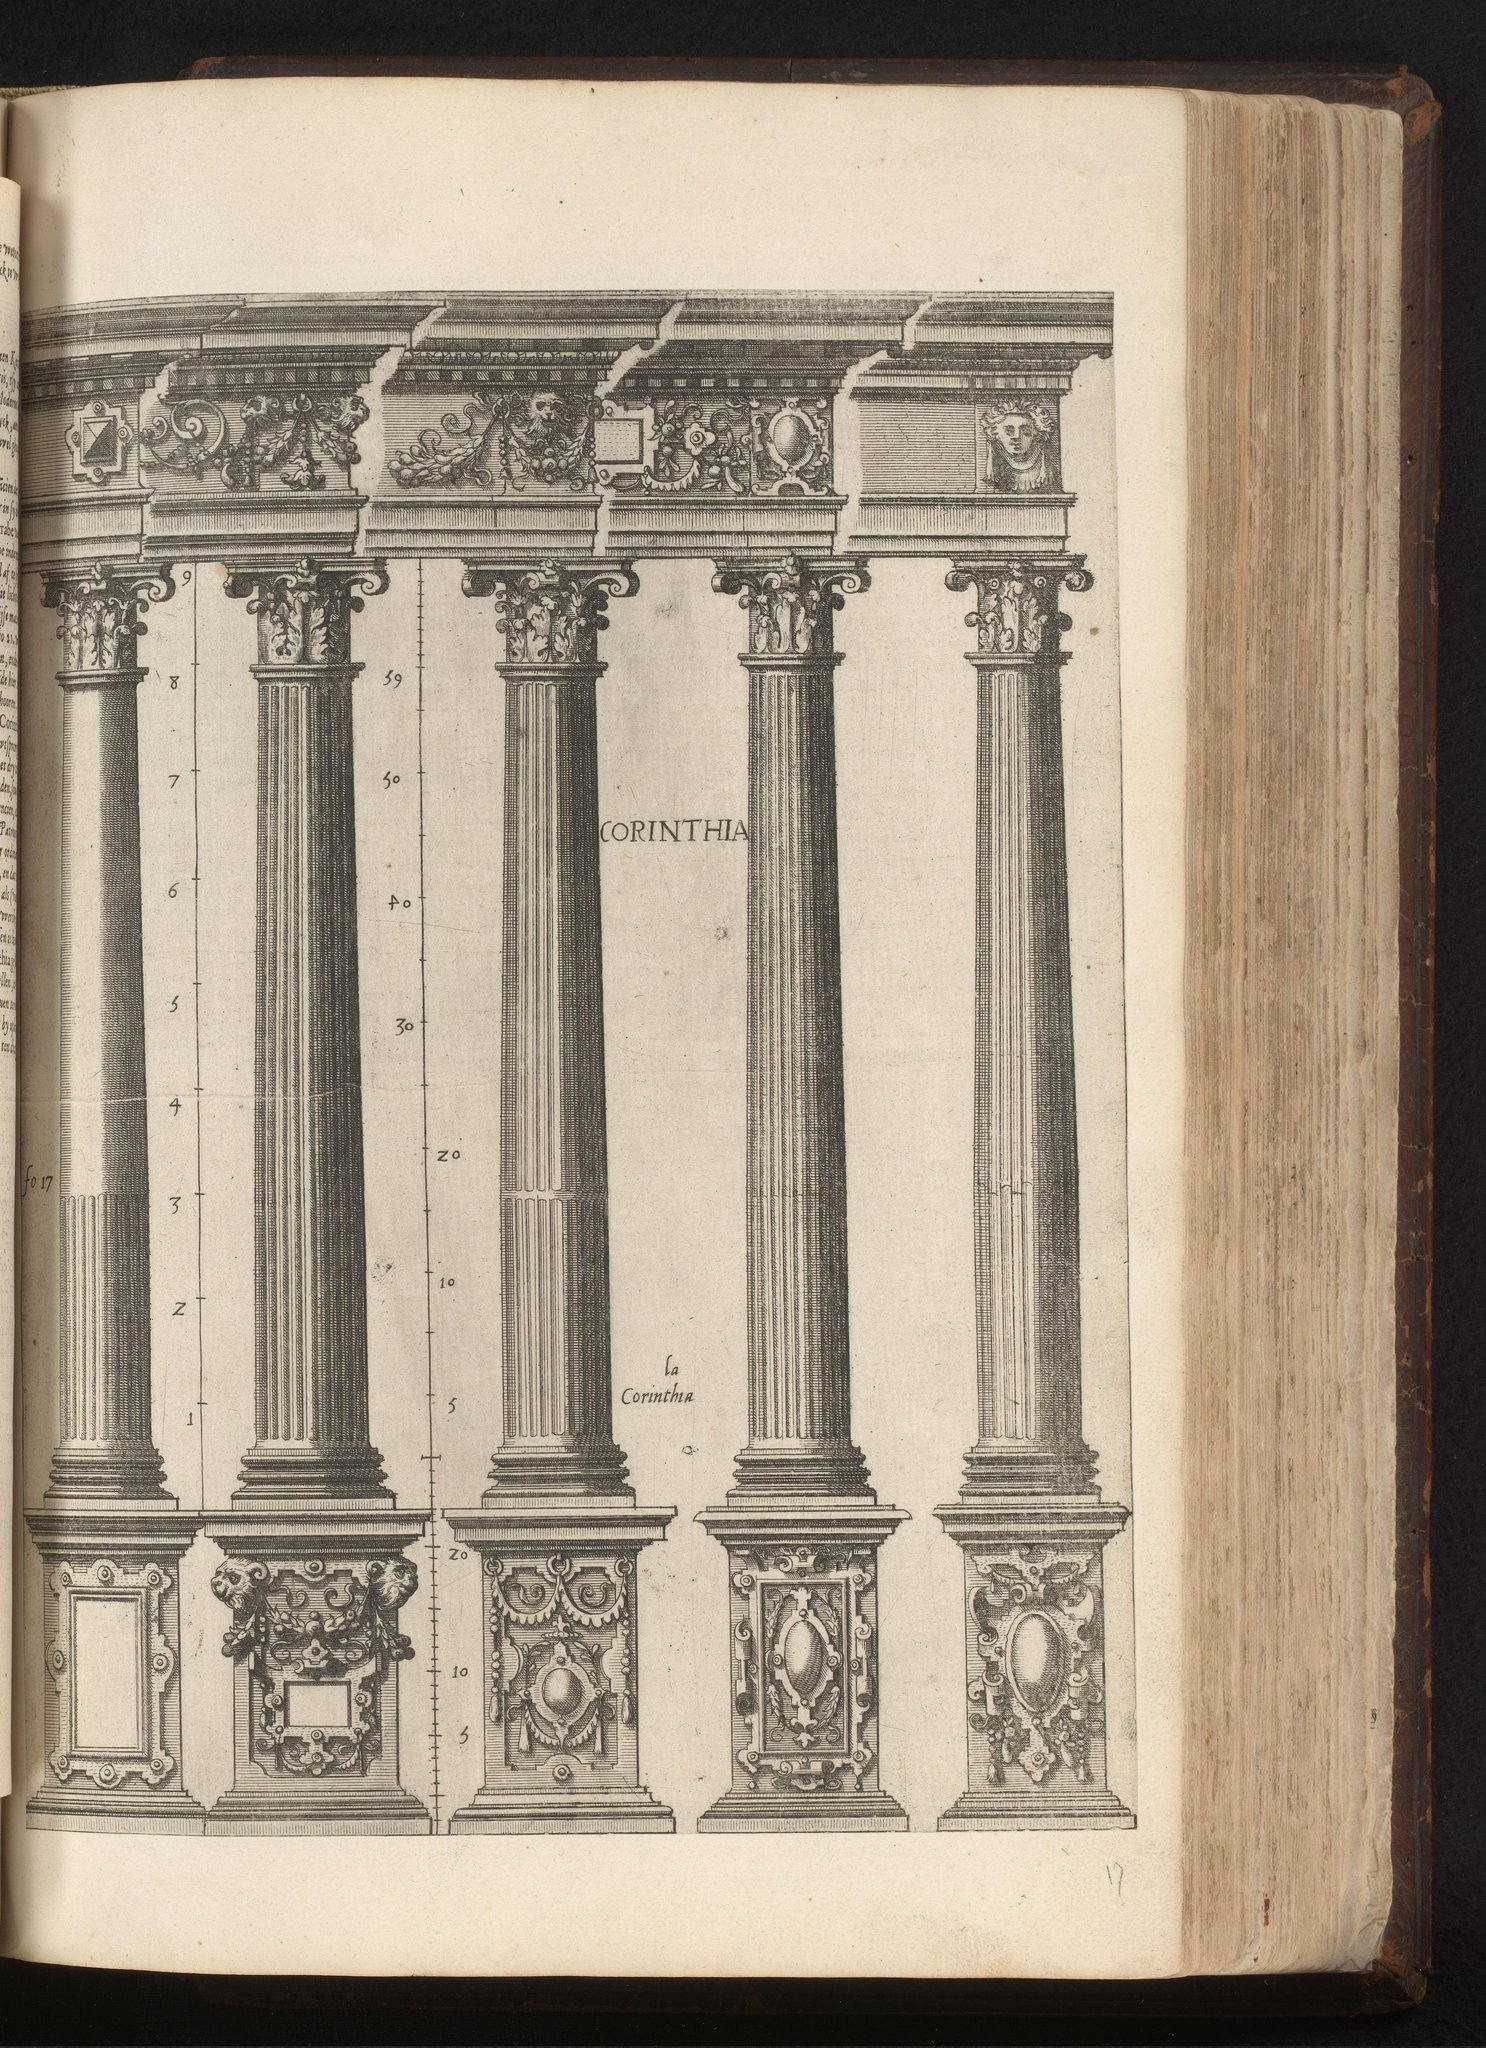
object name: album leaf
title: Korinthische zuilen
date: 1581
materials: paper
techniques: engraving, etching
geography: antwerp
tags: corinthian order ~ architecture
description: Prent uit: Vredeman de Vries, Hans. Architectura oder Bauung der Antiquen auss dem Vitruvius, waellches sein funff Collummen orden, (...). Antwerpen: Gerard de Jode en Gerard Smits, 1581. Prent eerder verschenen in de 1577-editie.